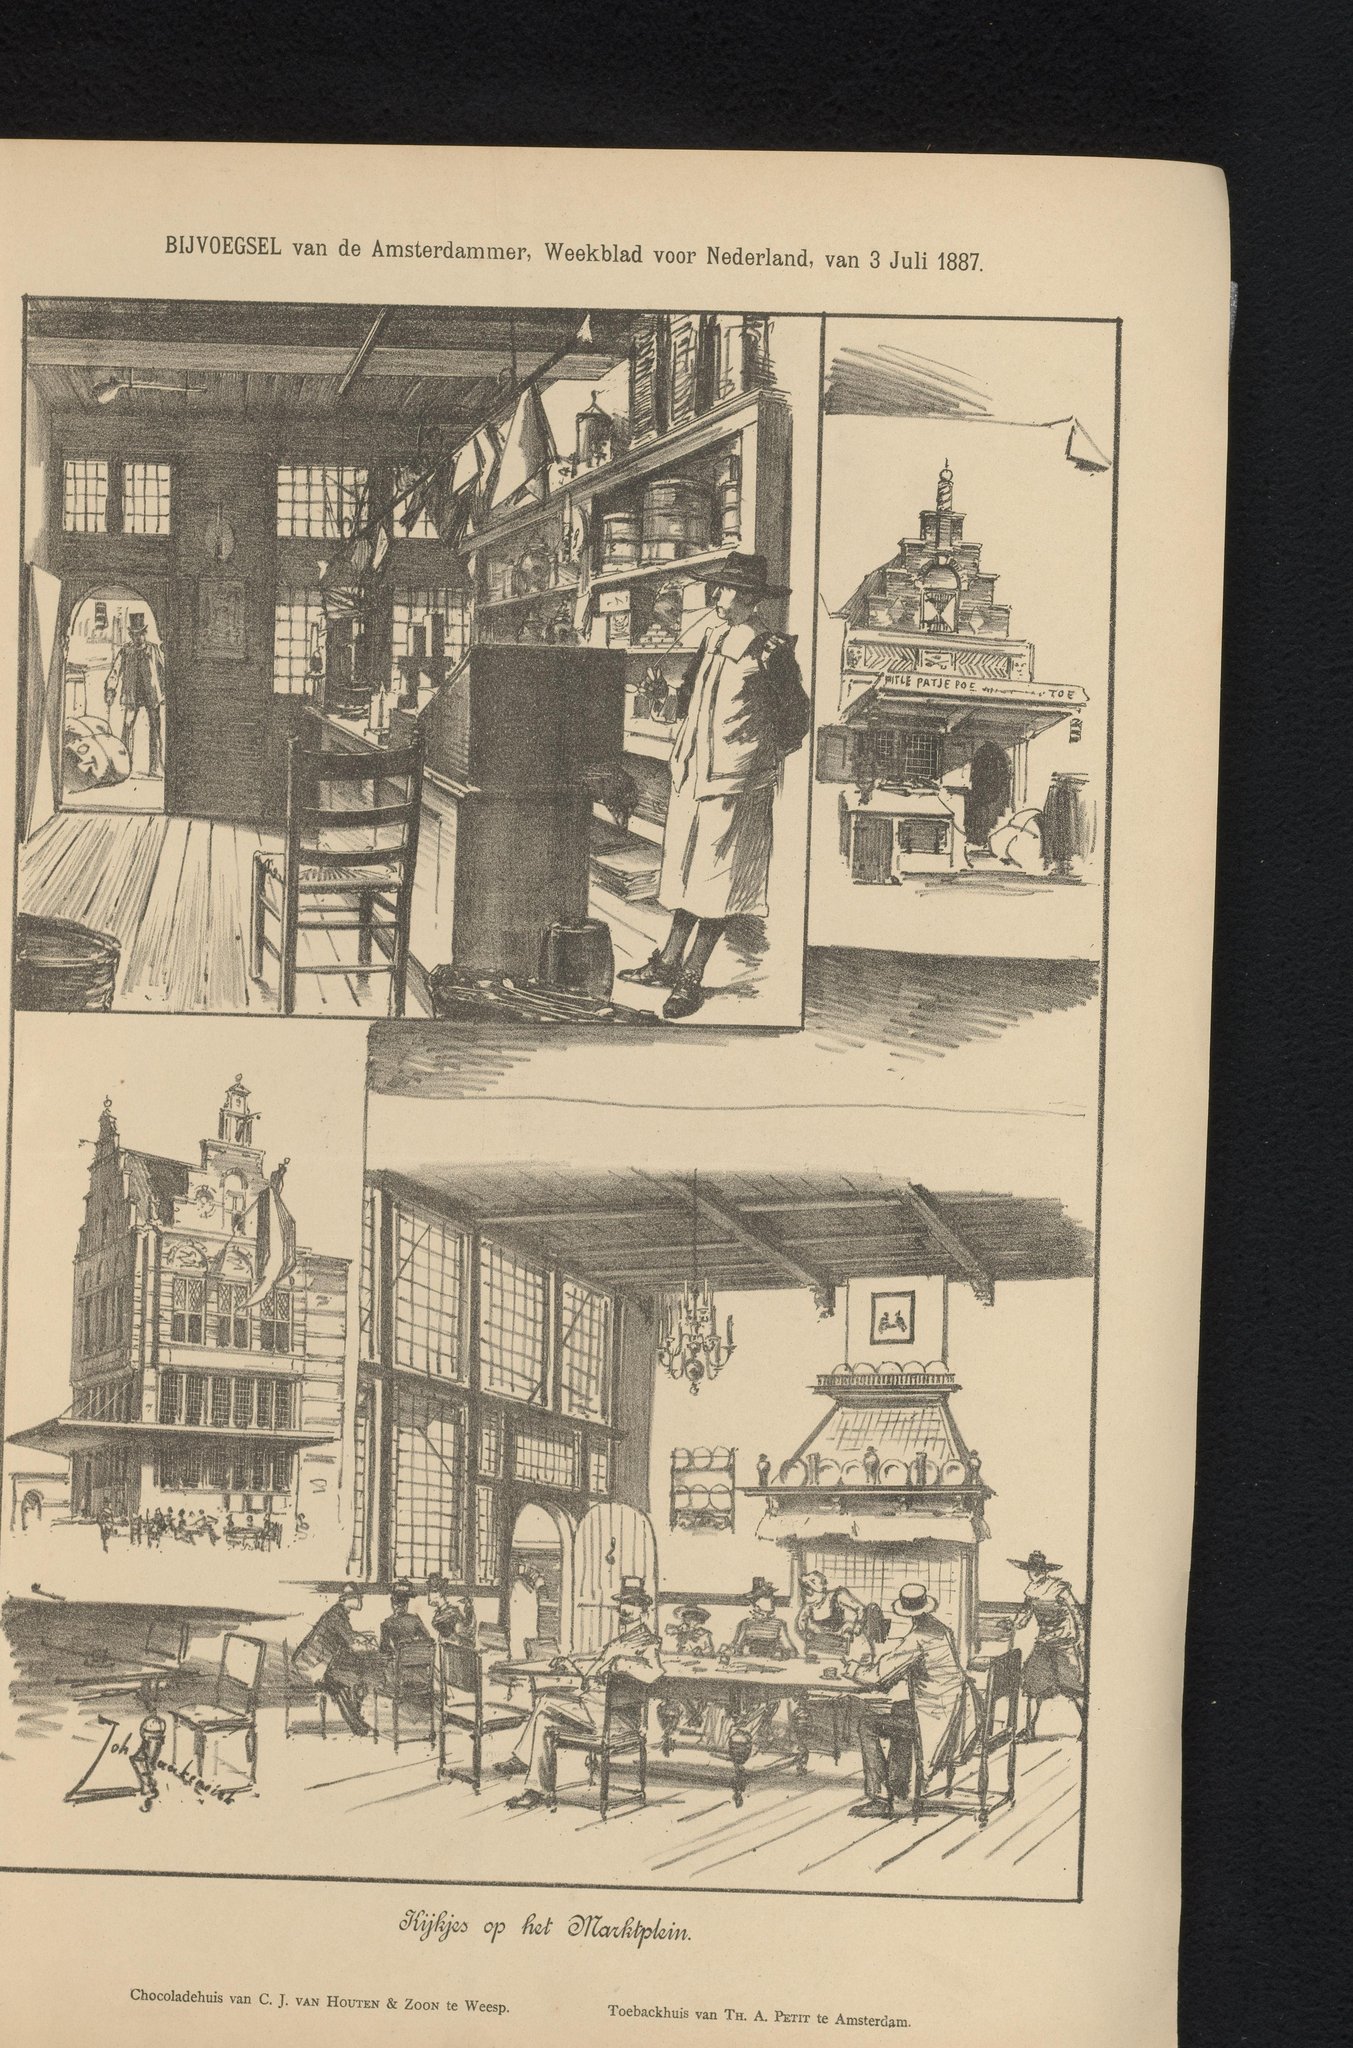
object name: print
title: Kijkjes op het Marktplein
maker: johan braakensiek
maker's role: draughtsman, print maker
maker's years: 1858-1940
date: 1887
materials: paper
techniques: lithograph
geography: netherlands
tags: square, place, circus, etc., chocolate, cocoa, representation of real building (either existing or having existed), amsterdam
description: Vier gezichten op en binnen verschillende gebouwen gevestigd aan marktpleinen in Nederland. Benoemd worden het Chocoladehuis van C.J. van Houten & Zoon te Weesp en het Toebackhuis van Th. A. Petit te Amsterdam.